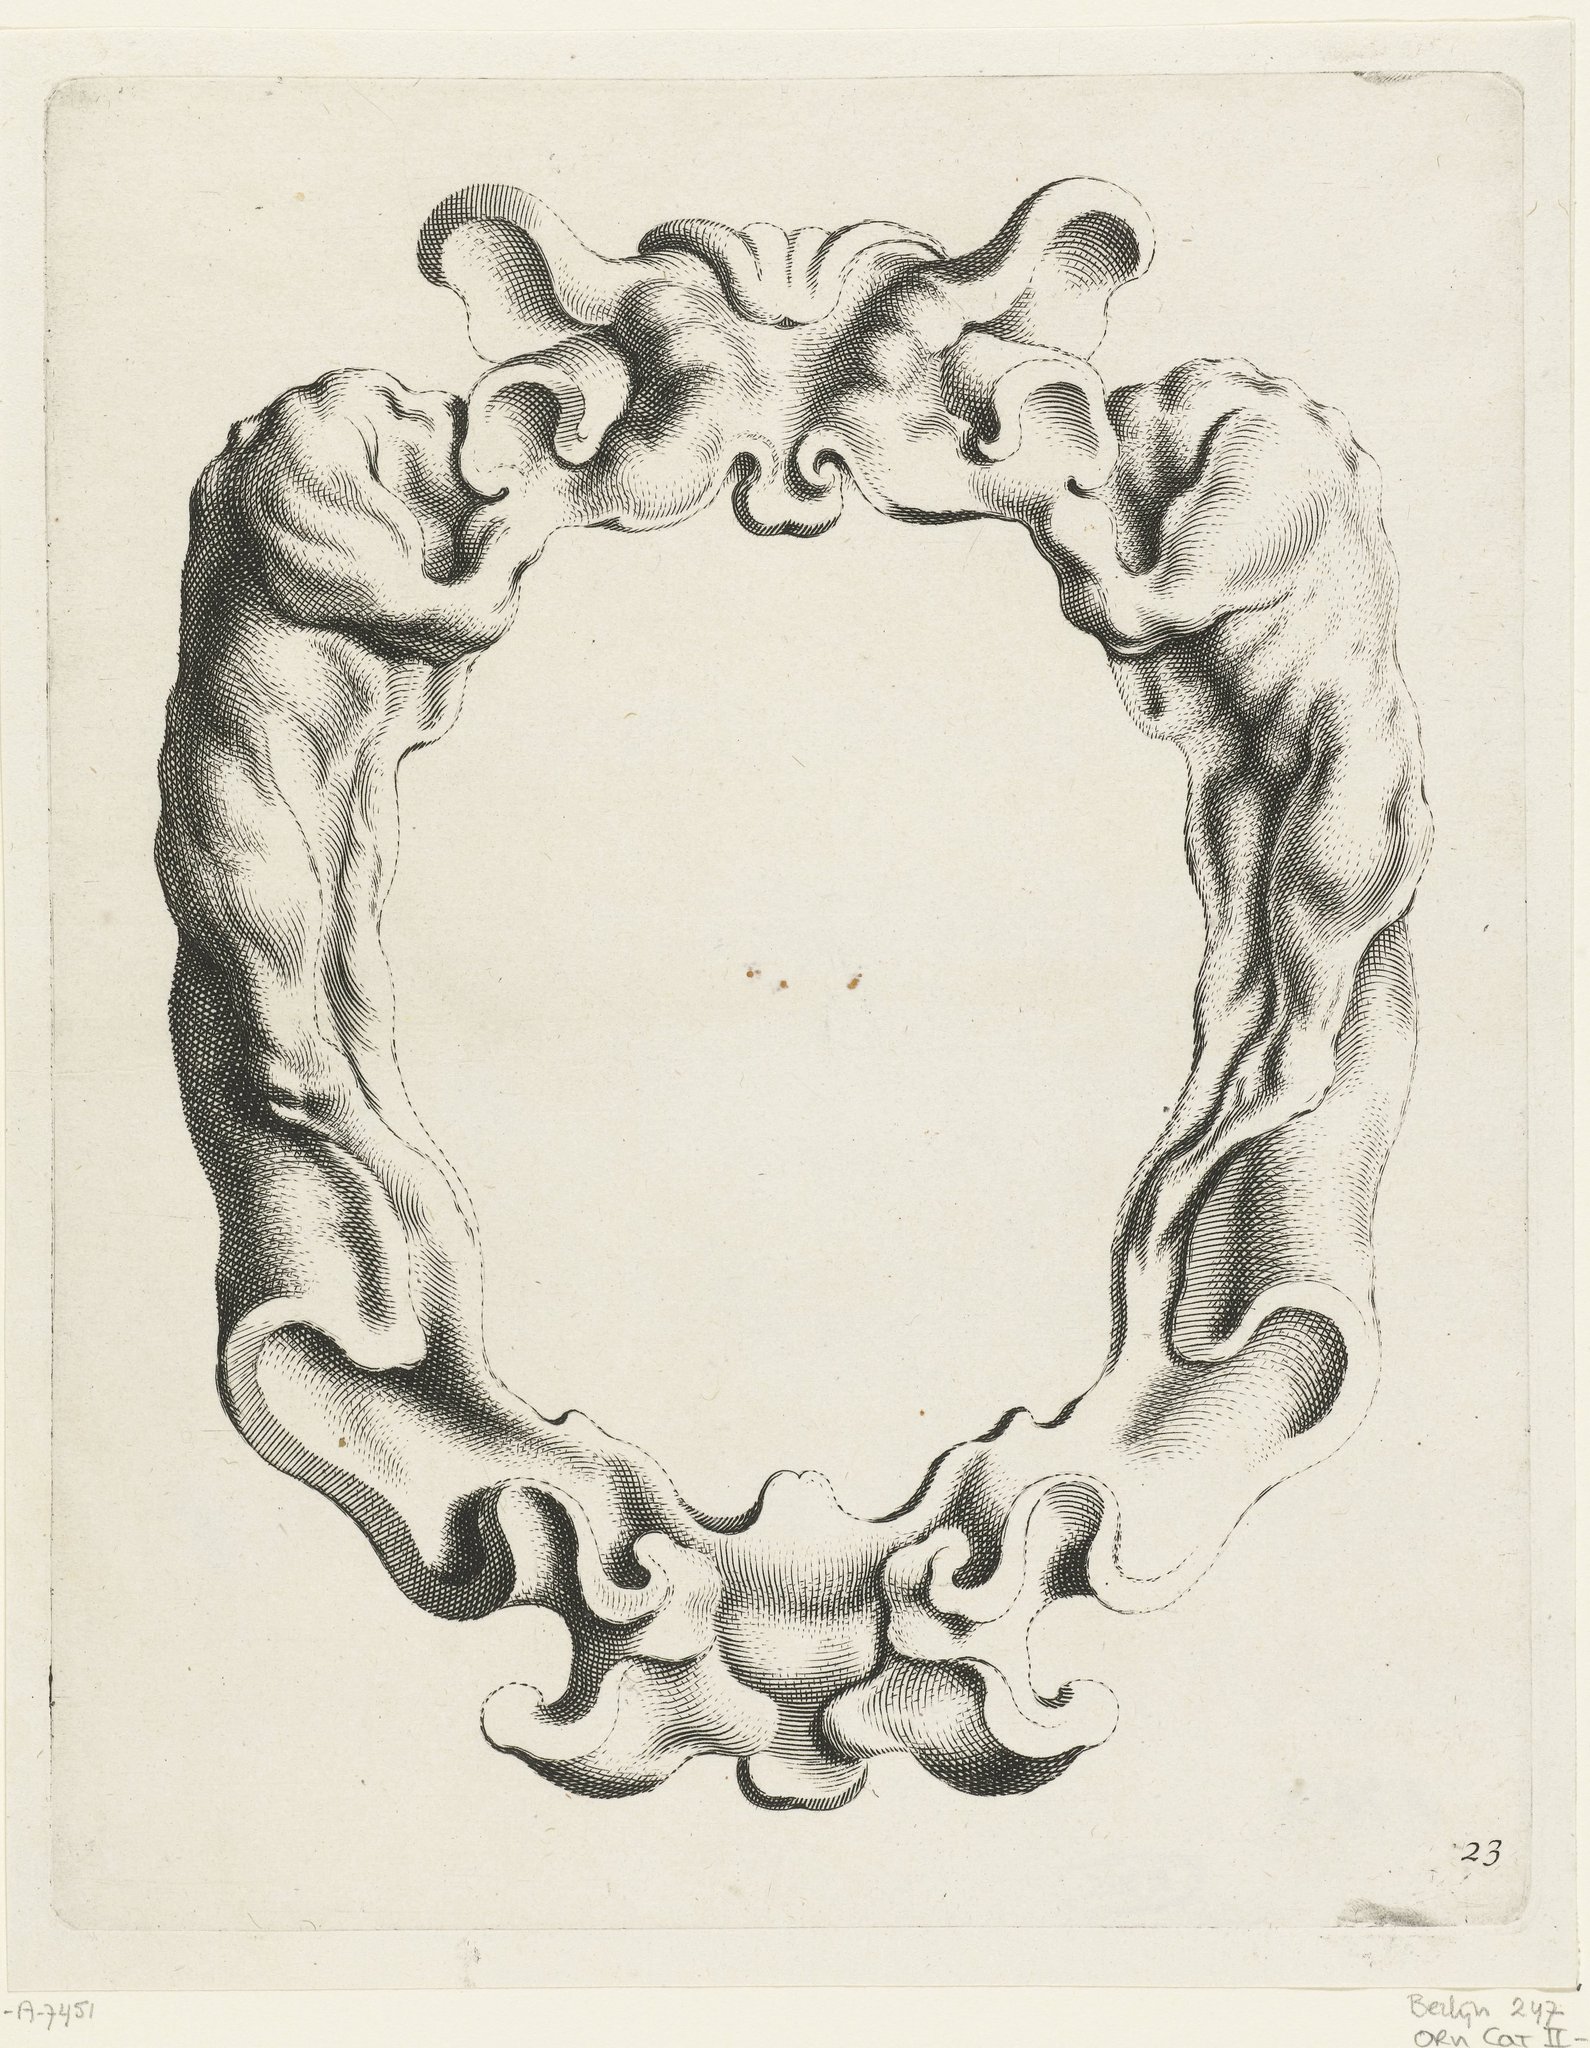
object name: ornament print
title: Cartouche met kwabornament met twee dieren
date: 1640-1655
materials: paper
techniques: engraving, etching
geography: amsterdam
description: De dieren zijn links en rechts opgenomen in de rand.